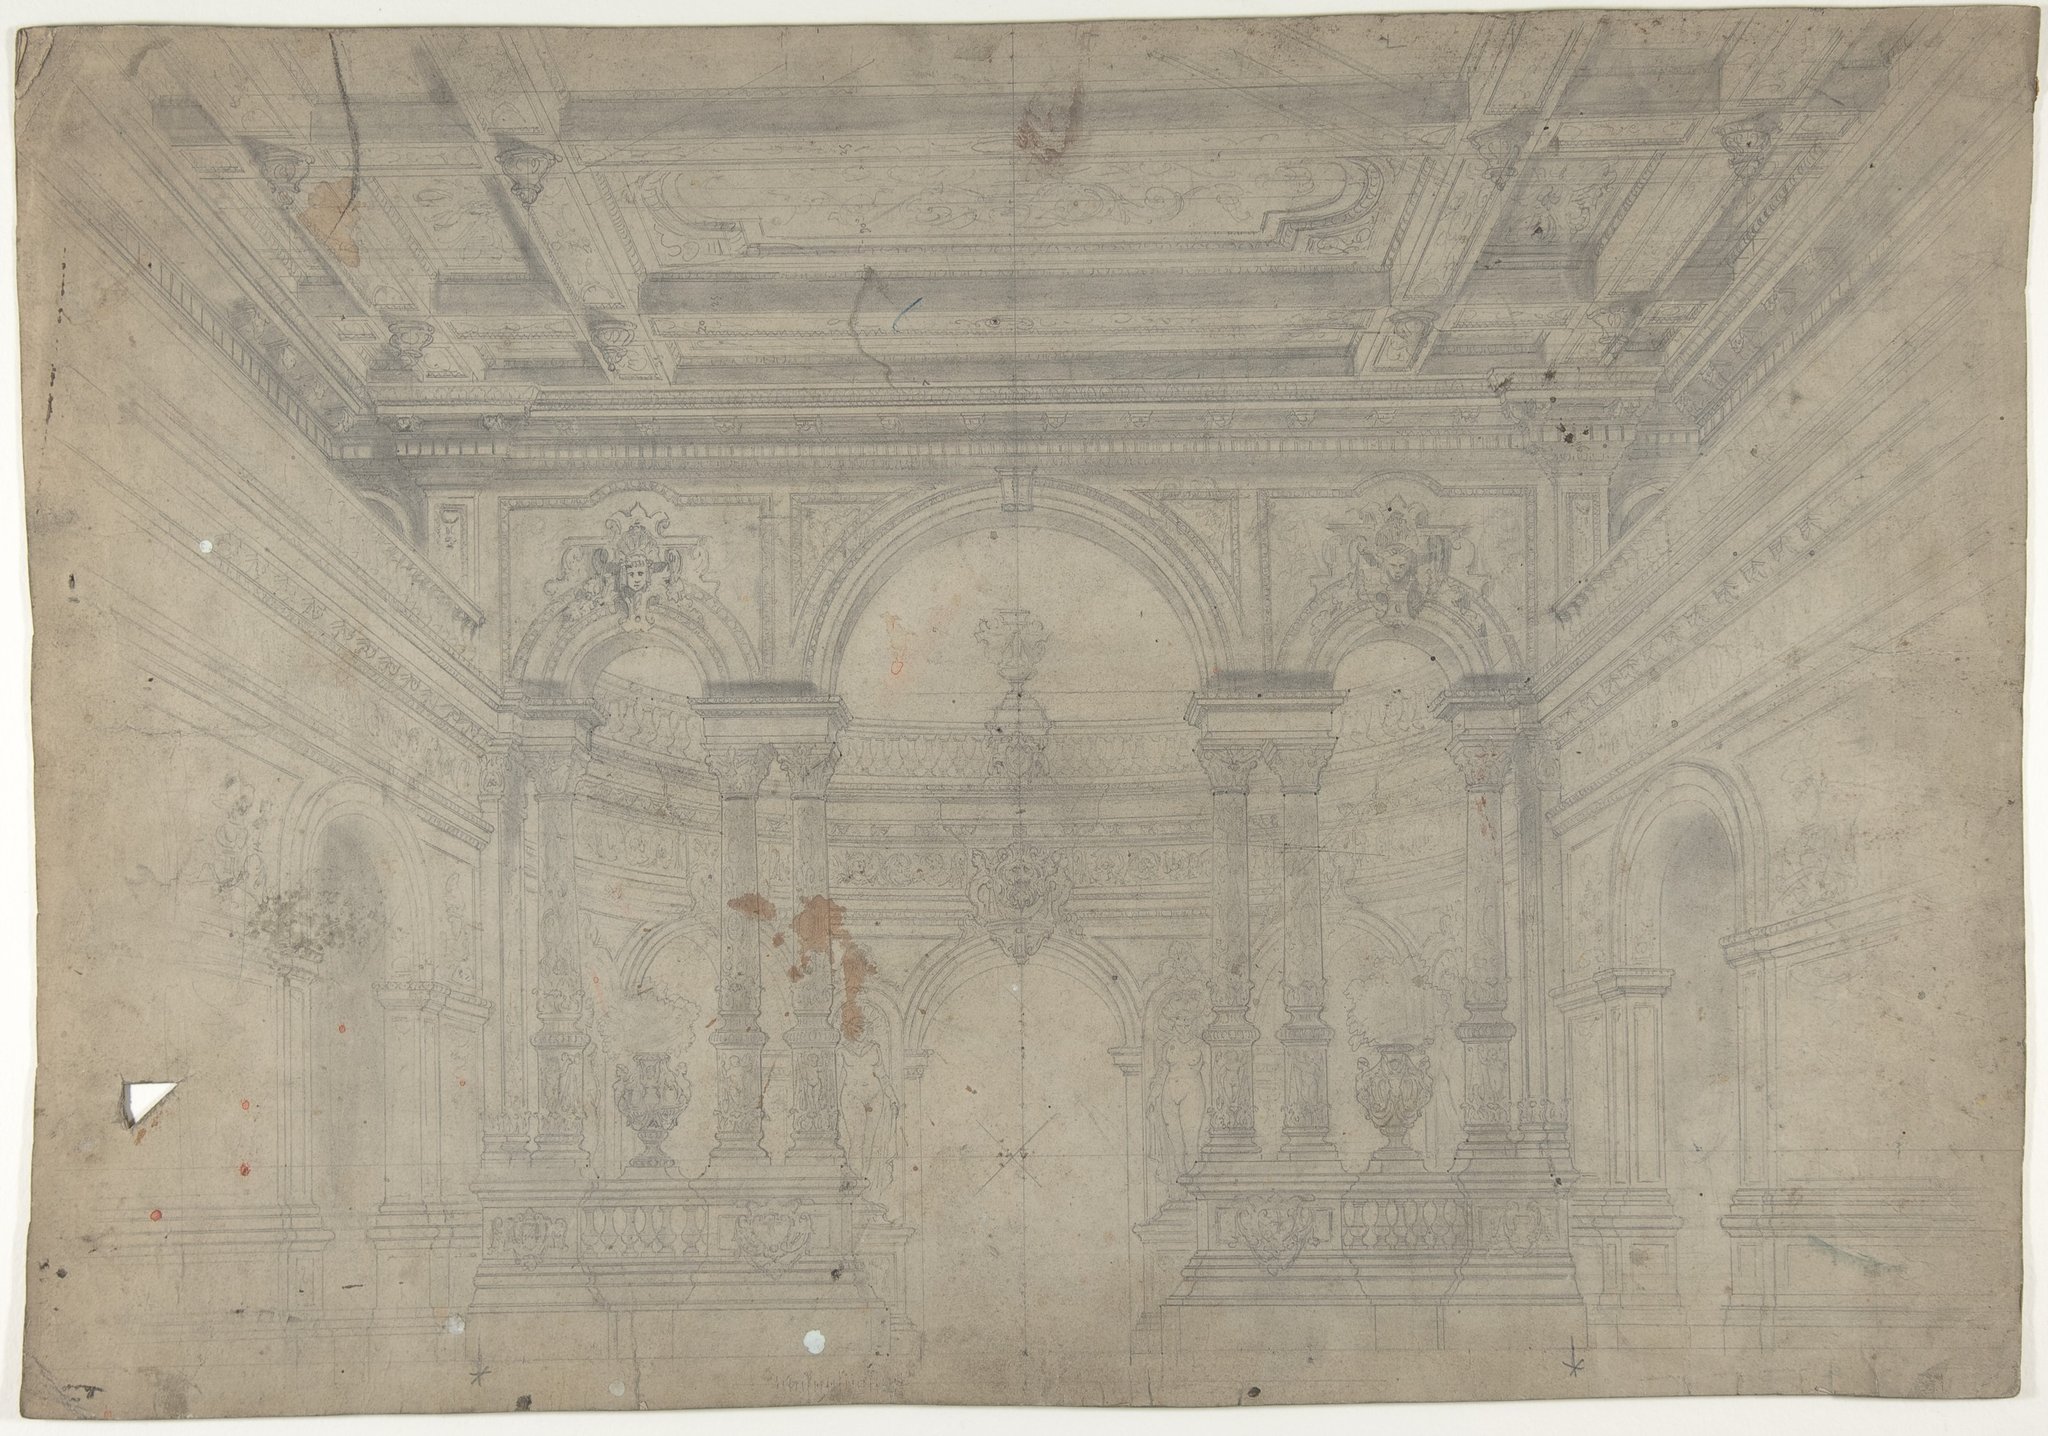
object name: drawing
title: Design for a Stage Set at the Opéra, Paris: Interior with Coiffered Ceiling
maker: eugène cicéri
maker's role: artist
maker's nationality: french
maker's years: 1813-1890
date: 1830-1890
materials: graphite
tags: stage design